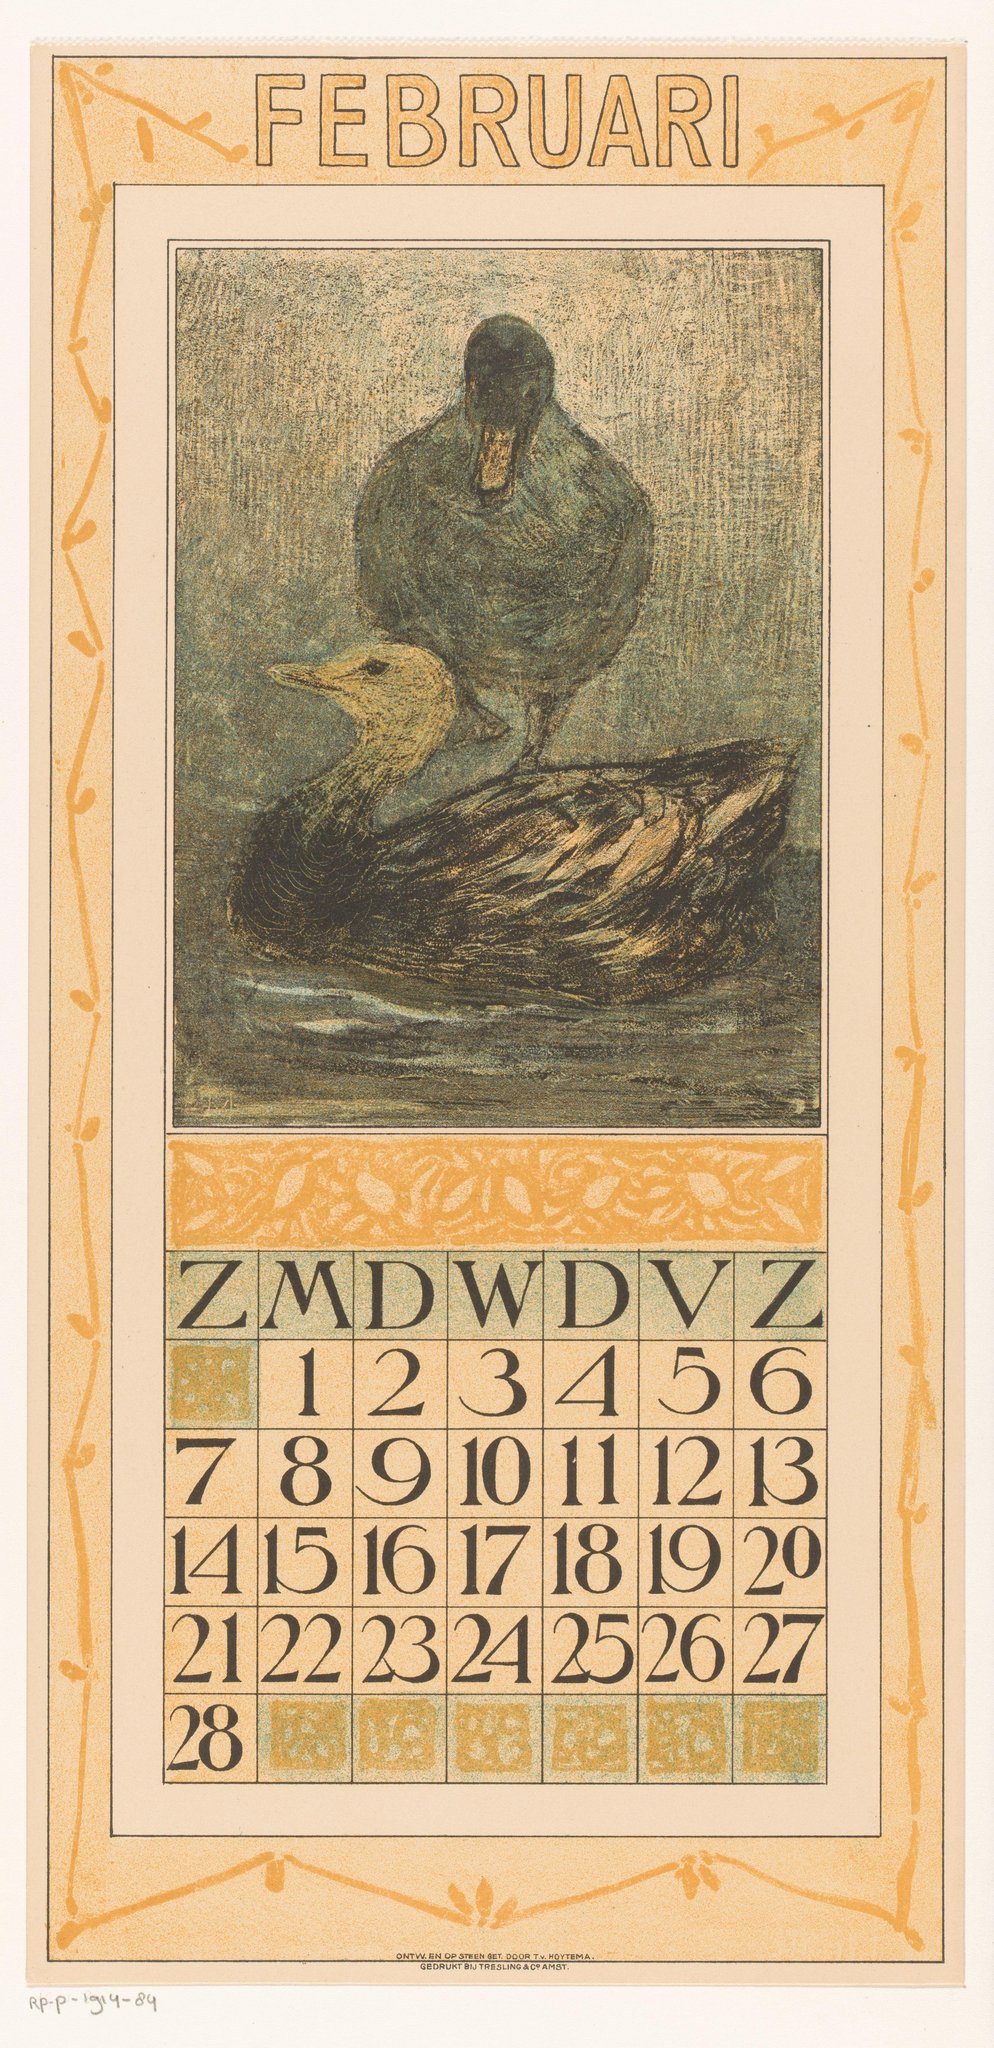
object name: calendar leaf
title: Kalender 1909 12 lithografien door Th. v. Hoytema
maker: theo van hoytema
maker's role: draughtsman, painter, print maker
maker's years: 1863-1917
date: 1908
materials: paper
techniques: lithograph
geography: the hague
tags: water-birds: duck, february ~ other concepts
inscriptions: collector's mark: Lugt 2228